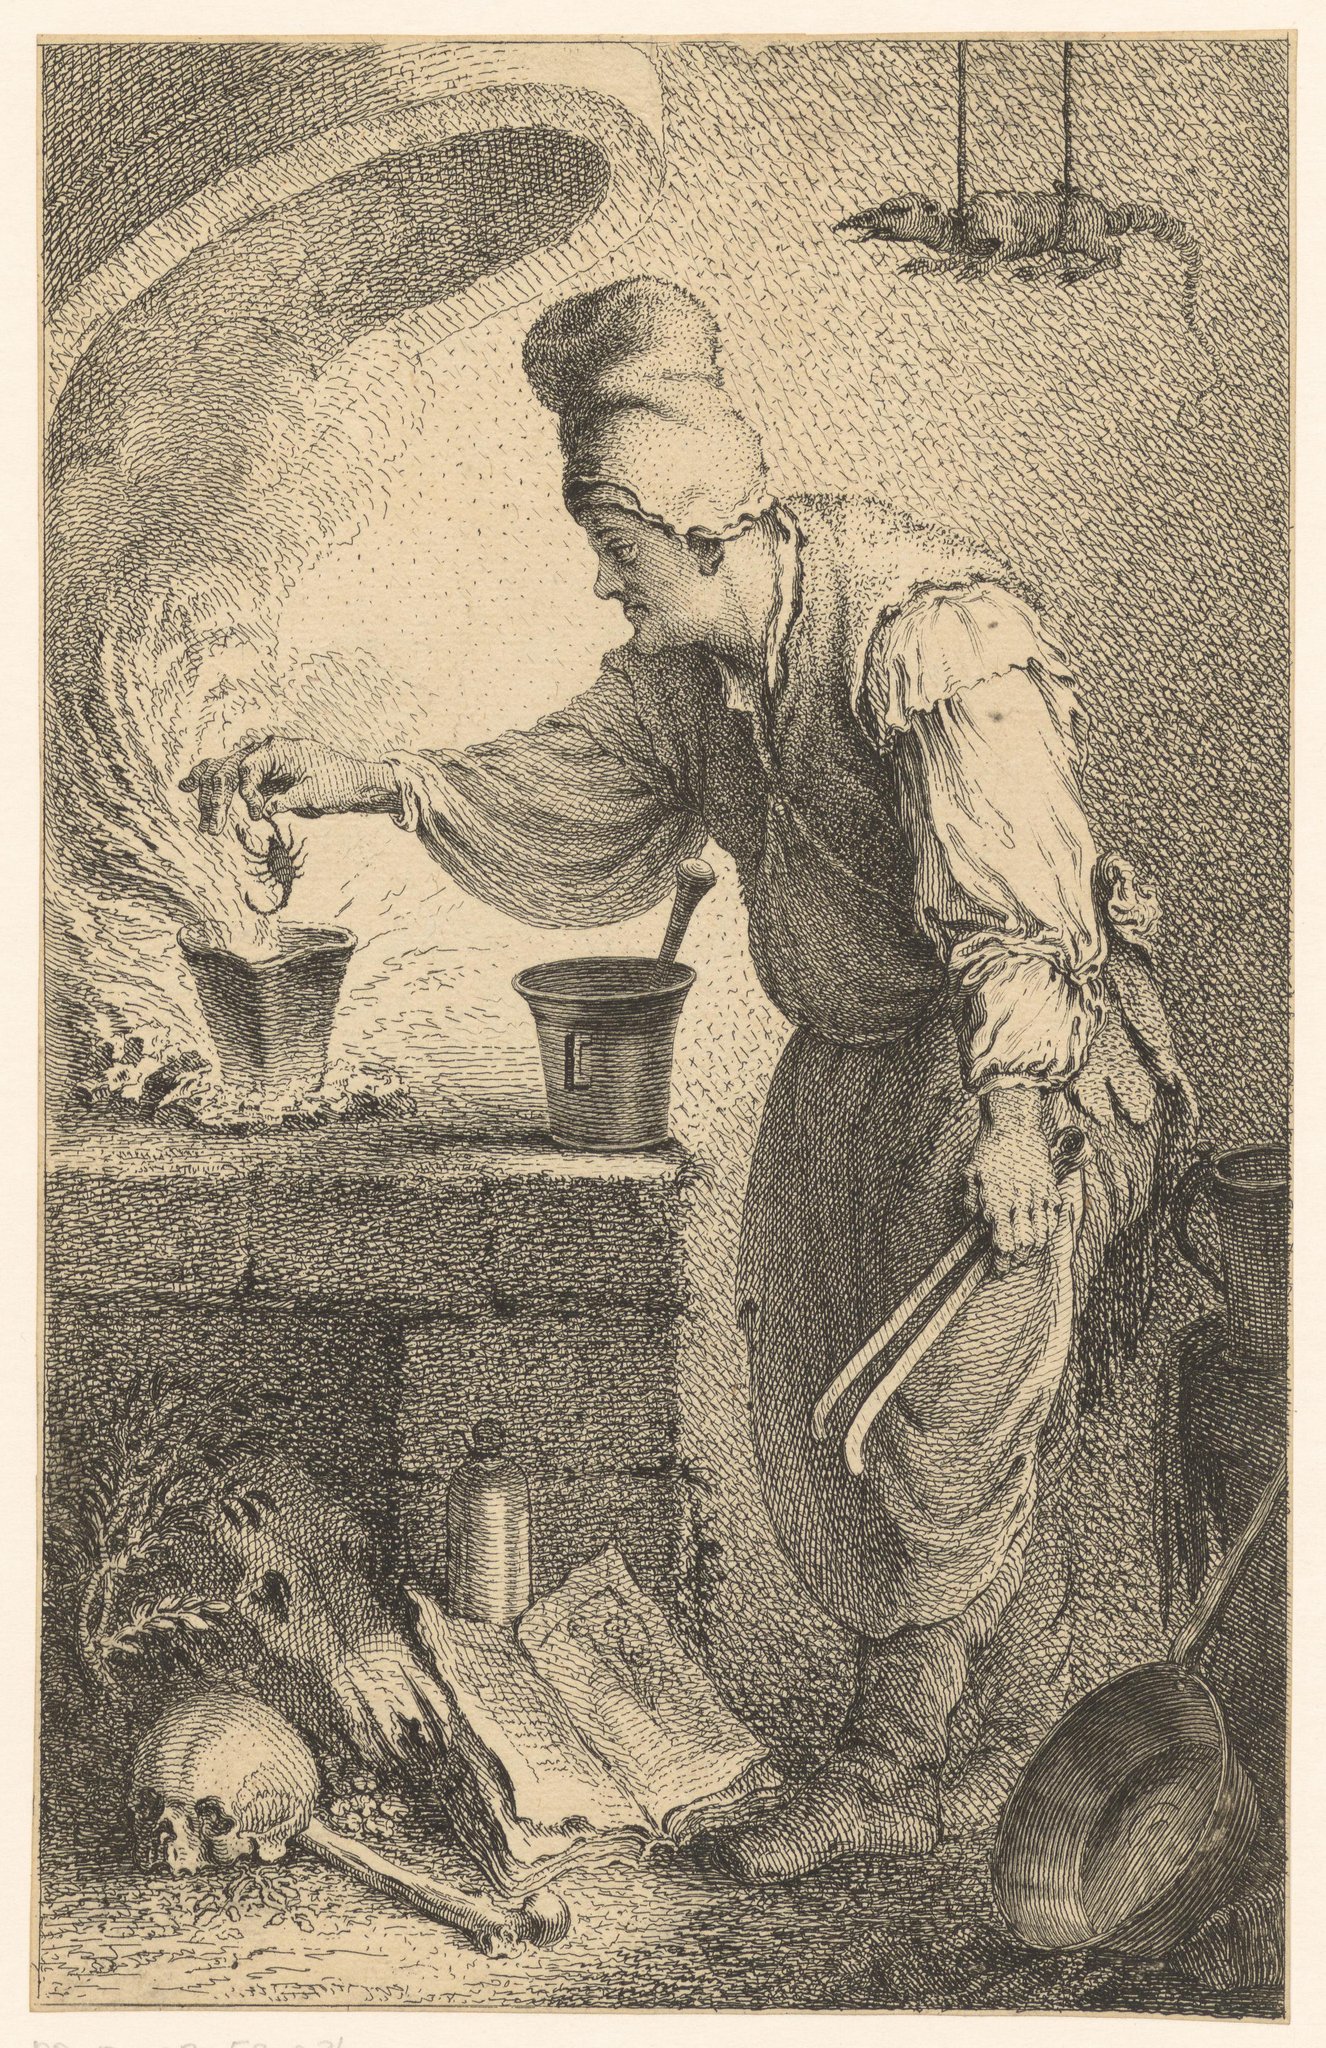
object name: print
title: Vrouw bij fornuis houdt een schorpioen boven een pan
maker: ferdinand landerer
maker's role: painter, print maker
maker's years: 1730-1795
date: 1740-1795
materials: paper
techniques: etching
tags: witch, sorceress, unprofessional or illegal practice, popular medicine, brewing, boiling (in a cauldron); witches' kitchen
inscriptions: collector's mark: Lugt 2228